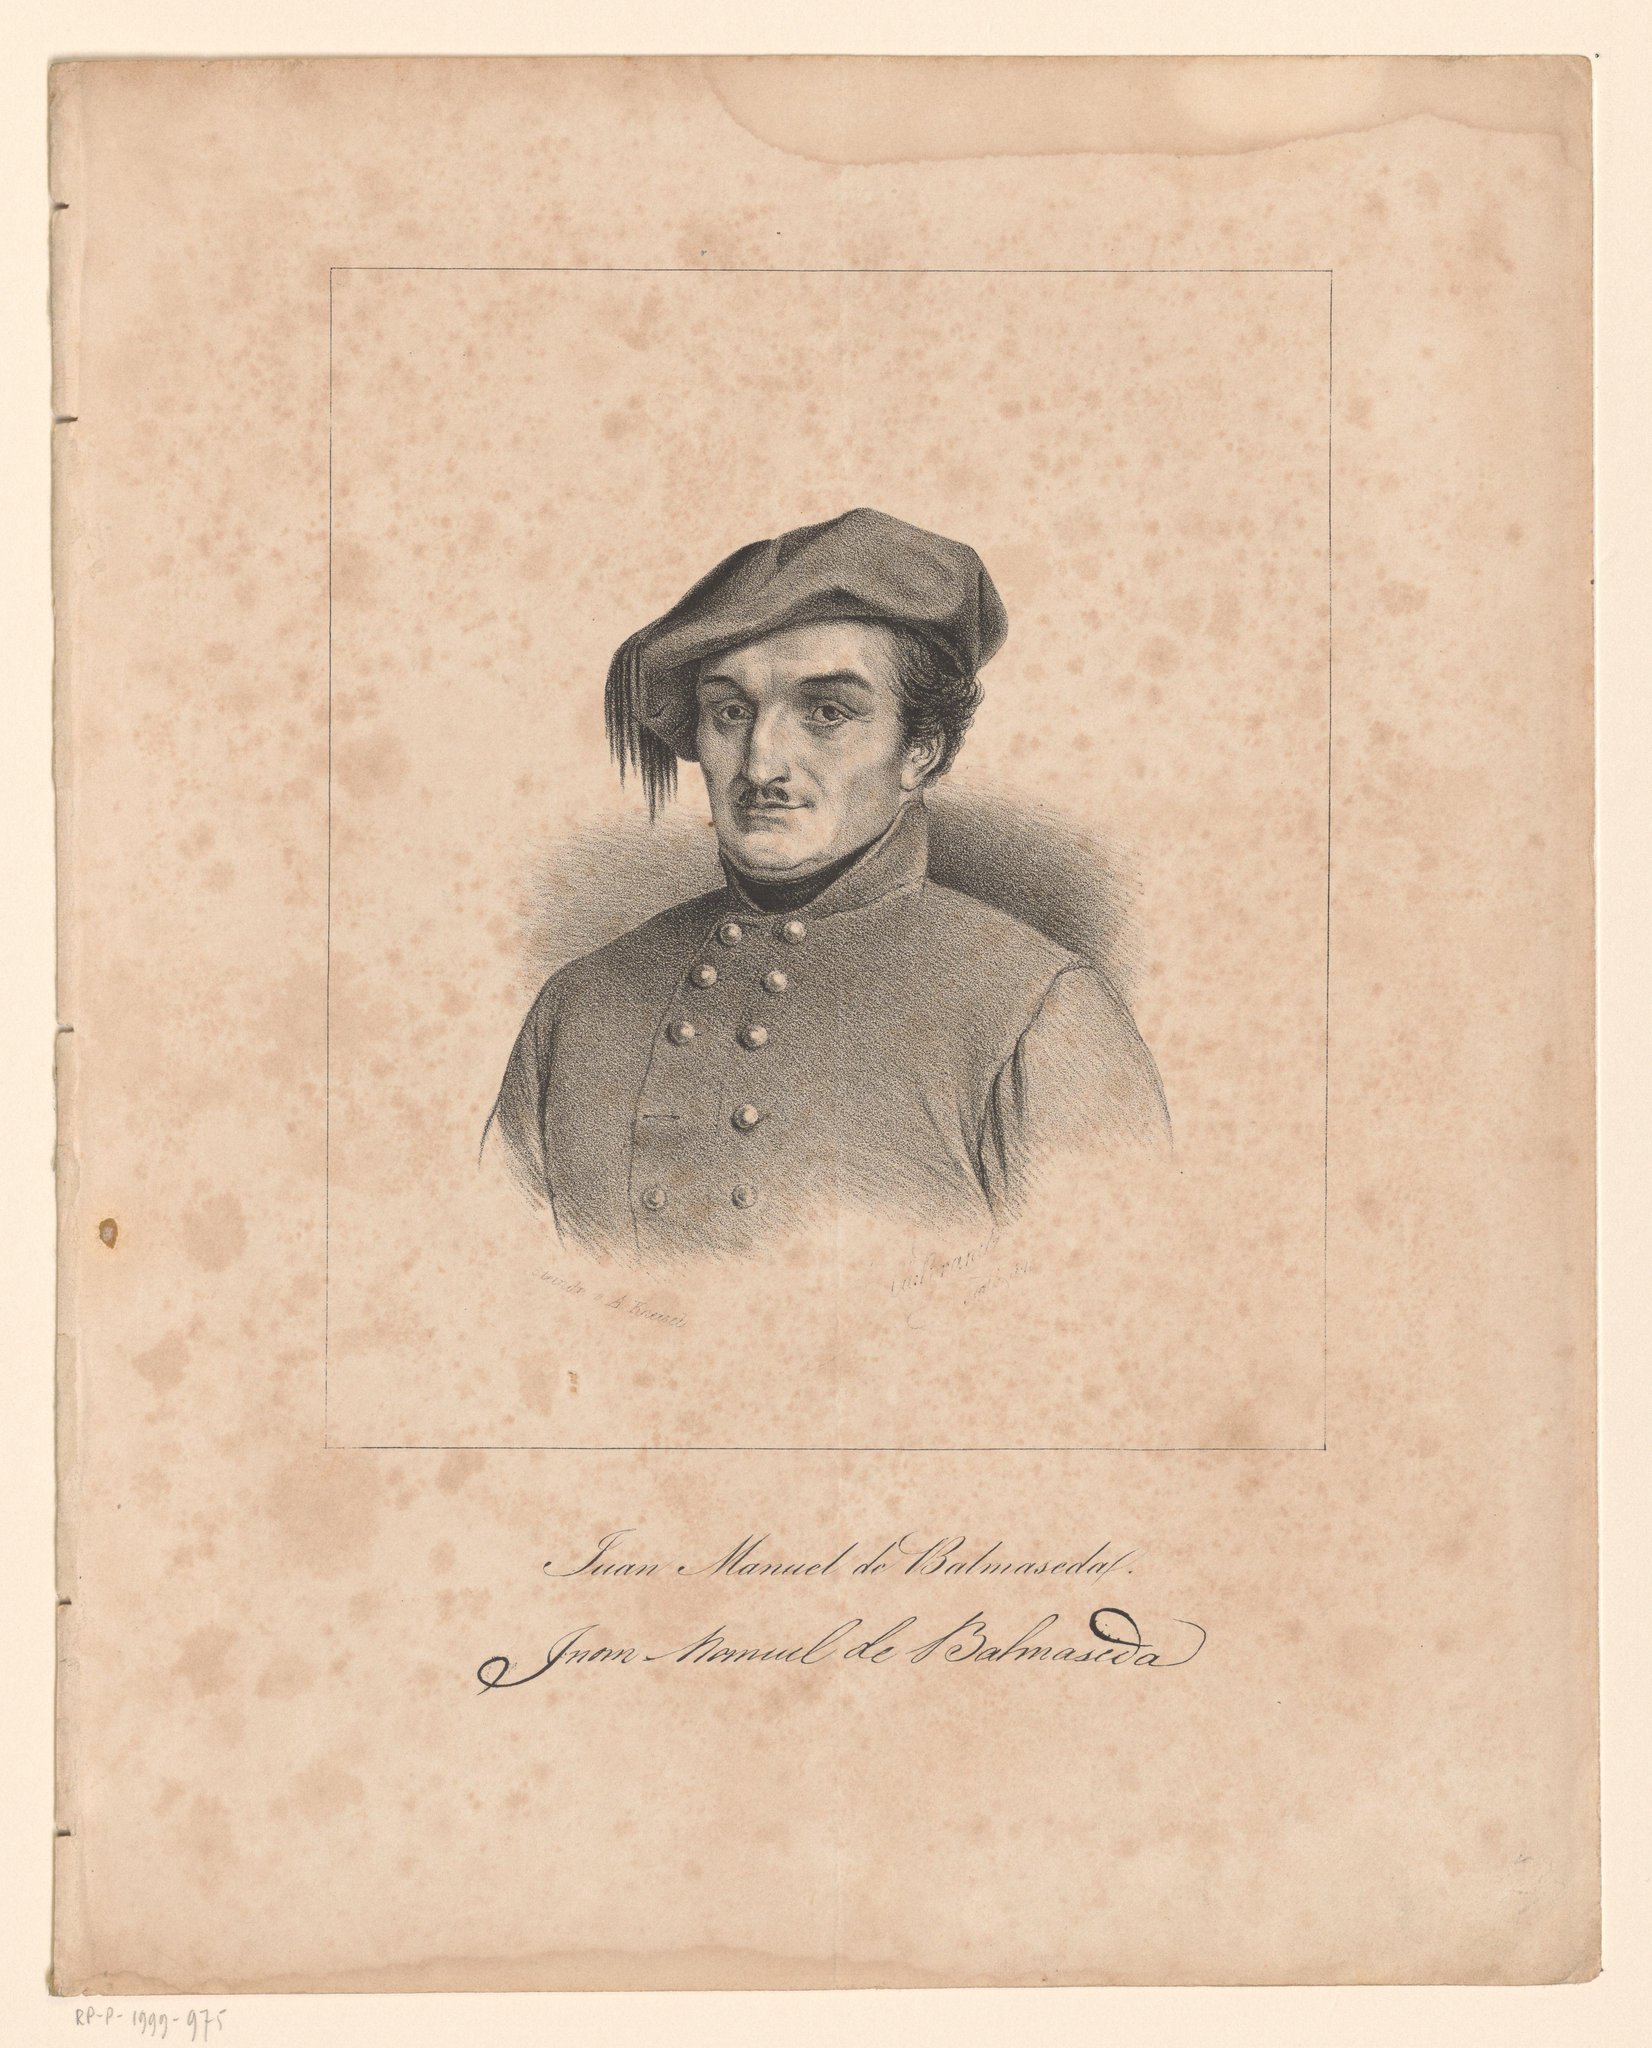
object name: print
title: Portret van Juan Manuel Balmaseda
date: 1840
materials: paper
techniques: lithograph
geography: leipzig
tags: historical persons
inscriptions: collector's mark: Lugt 2760, collector's mark: Lugt 2228